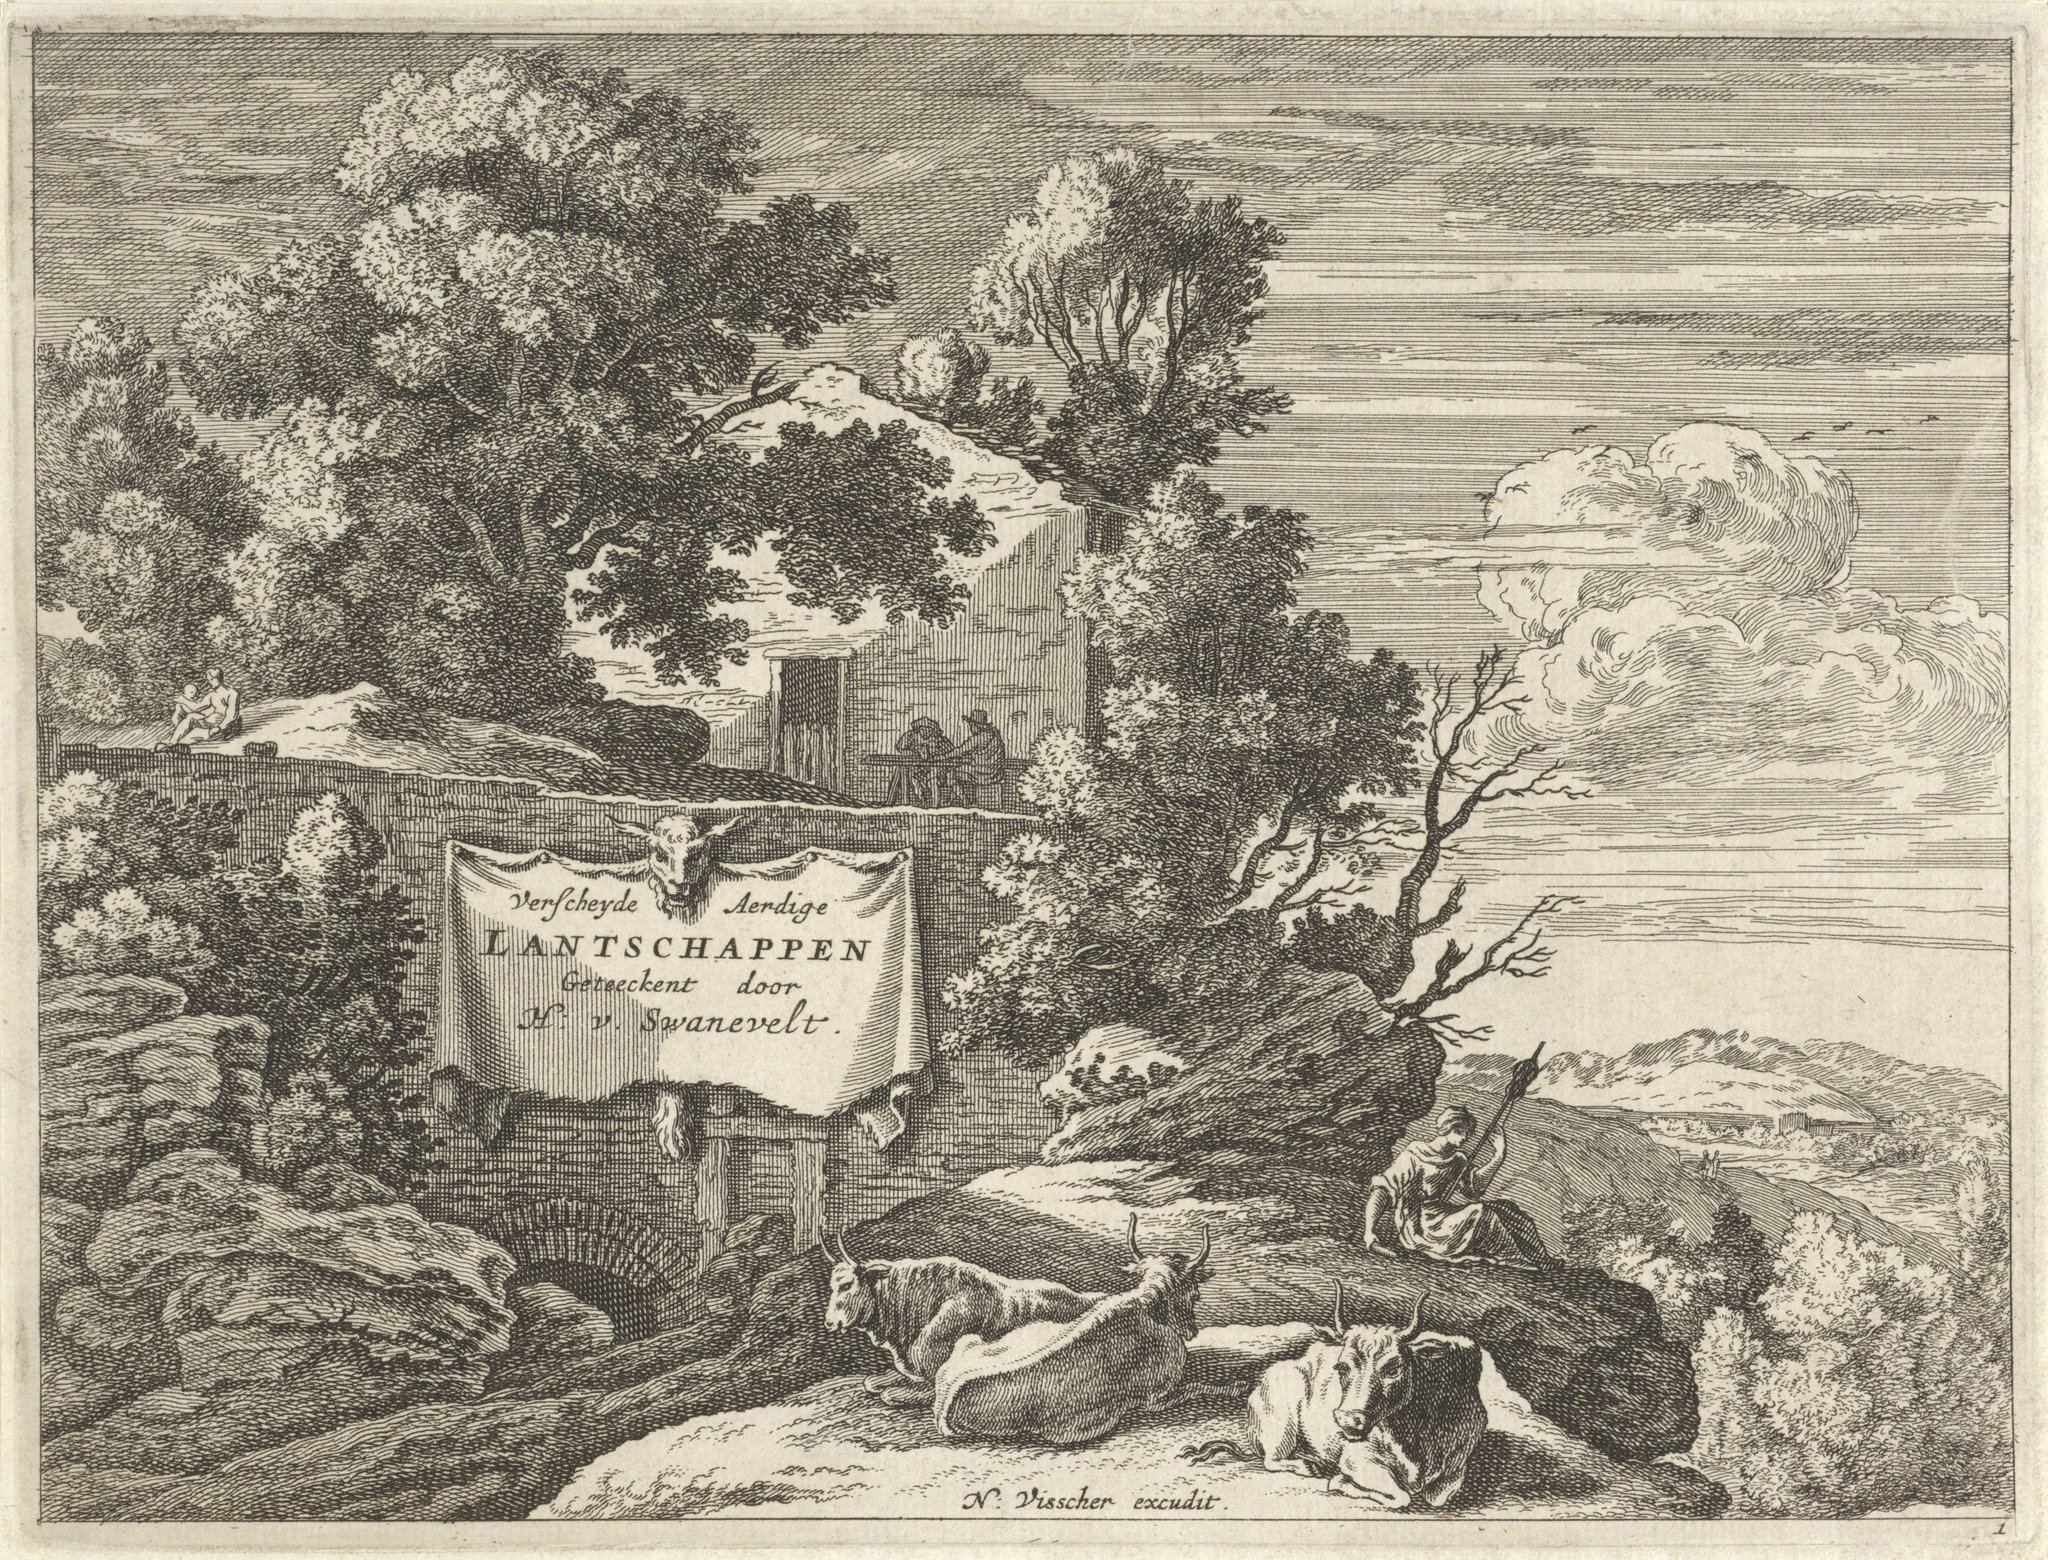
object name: titelprent, frontispice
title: Verscheyde aerdige lantschappen (...)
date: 1643-1679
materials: paper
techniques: etching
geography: amsterdam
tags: cow, landscapes, rural housing, e.g. country-house, villa, cottage, spindle, drapery, draped garment, 'gewandgebung'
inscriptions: collector's mark: Lugt 240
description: Voor een gebouw op een wal zit een spinster bij enkele koeien.